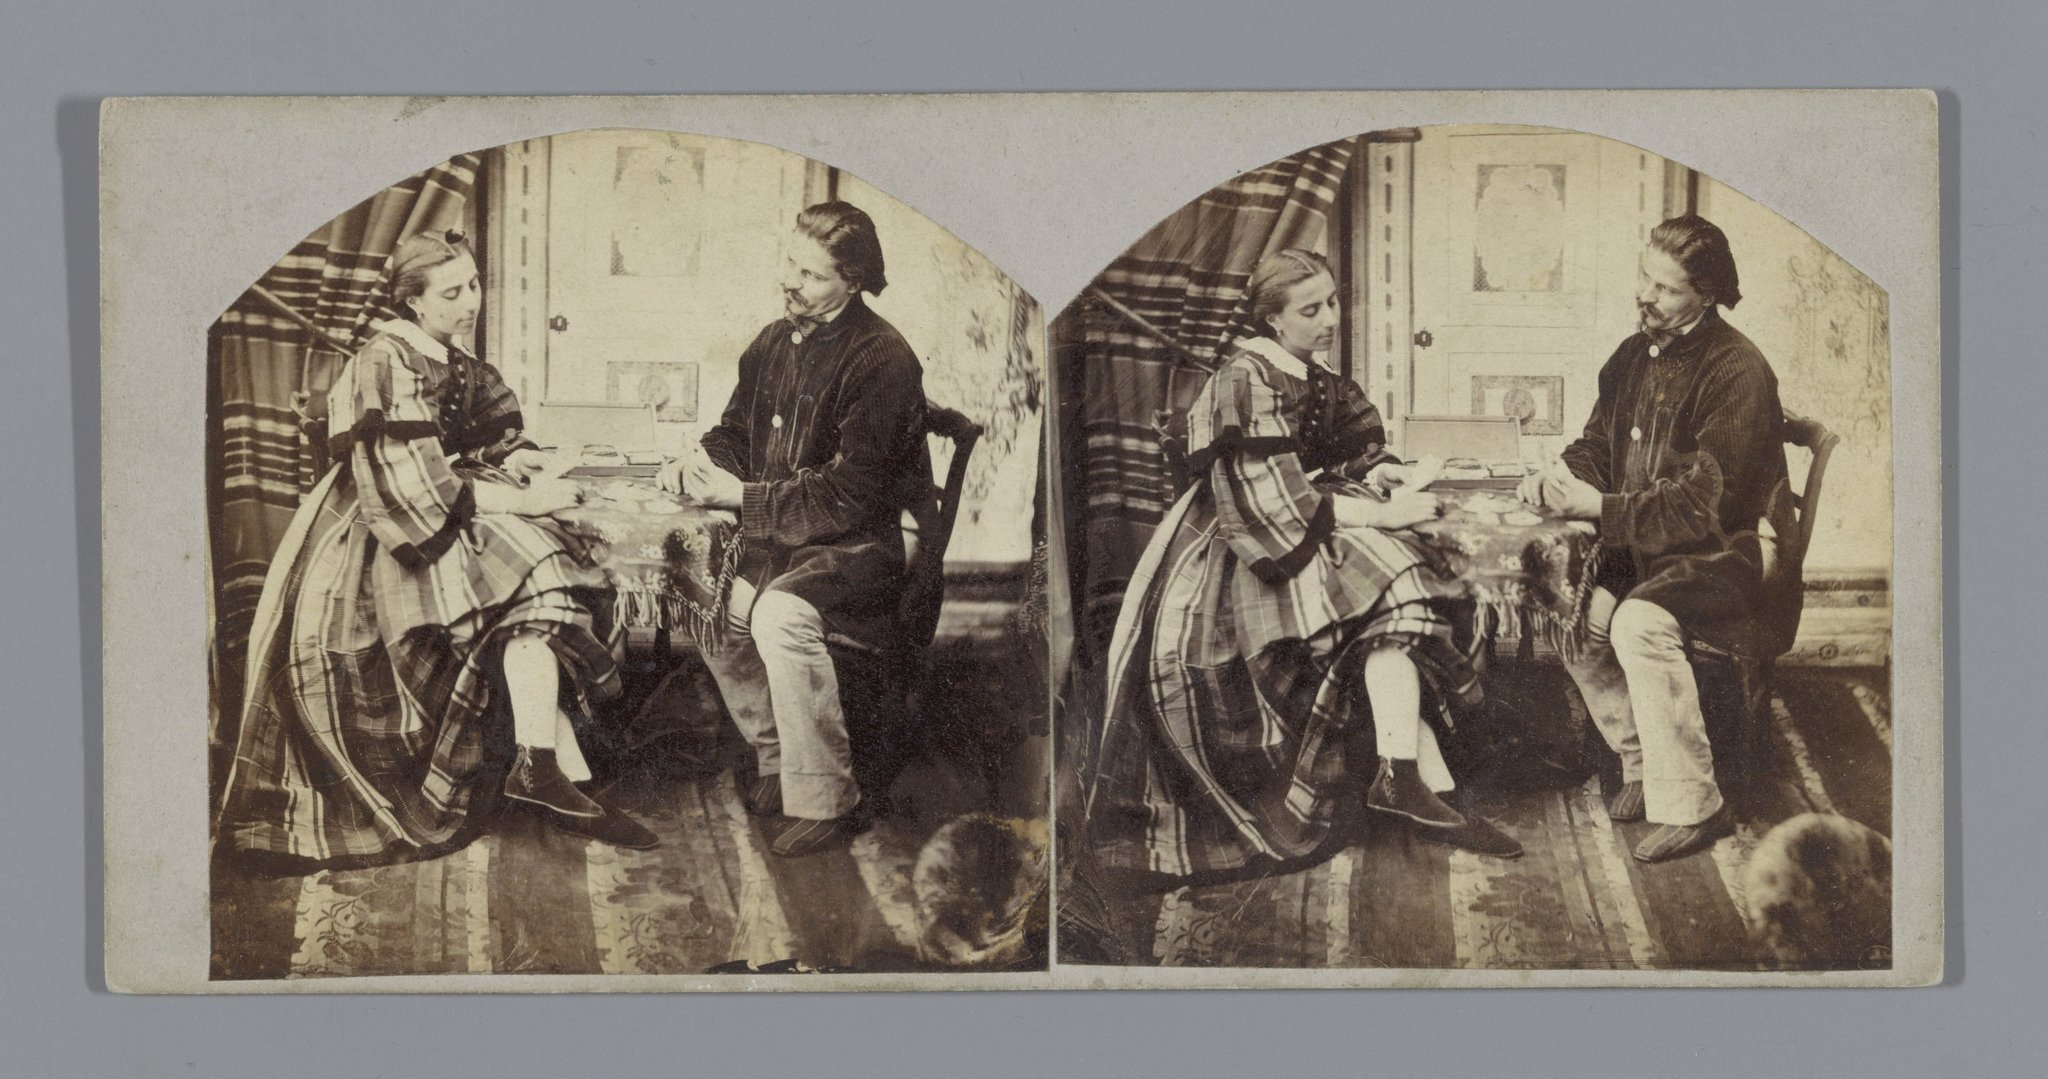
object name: stereograph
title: Man en vrouw zittend in interieur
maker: Anonymous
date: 1860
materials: cardboard, photographic support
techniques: albumen print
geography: paris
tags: living-room, parlour, sitting-room, paris